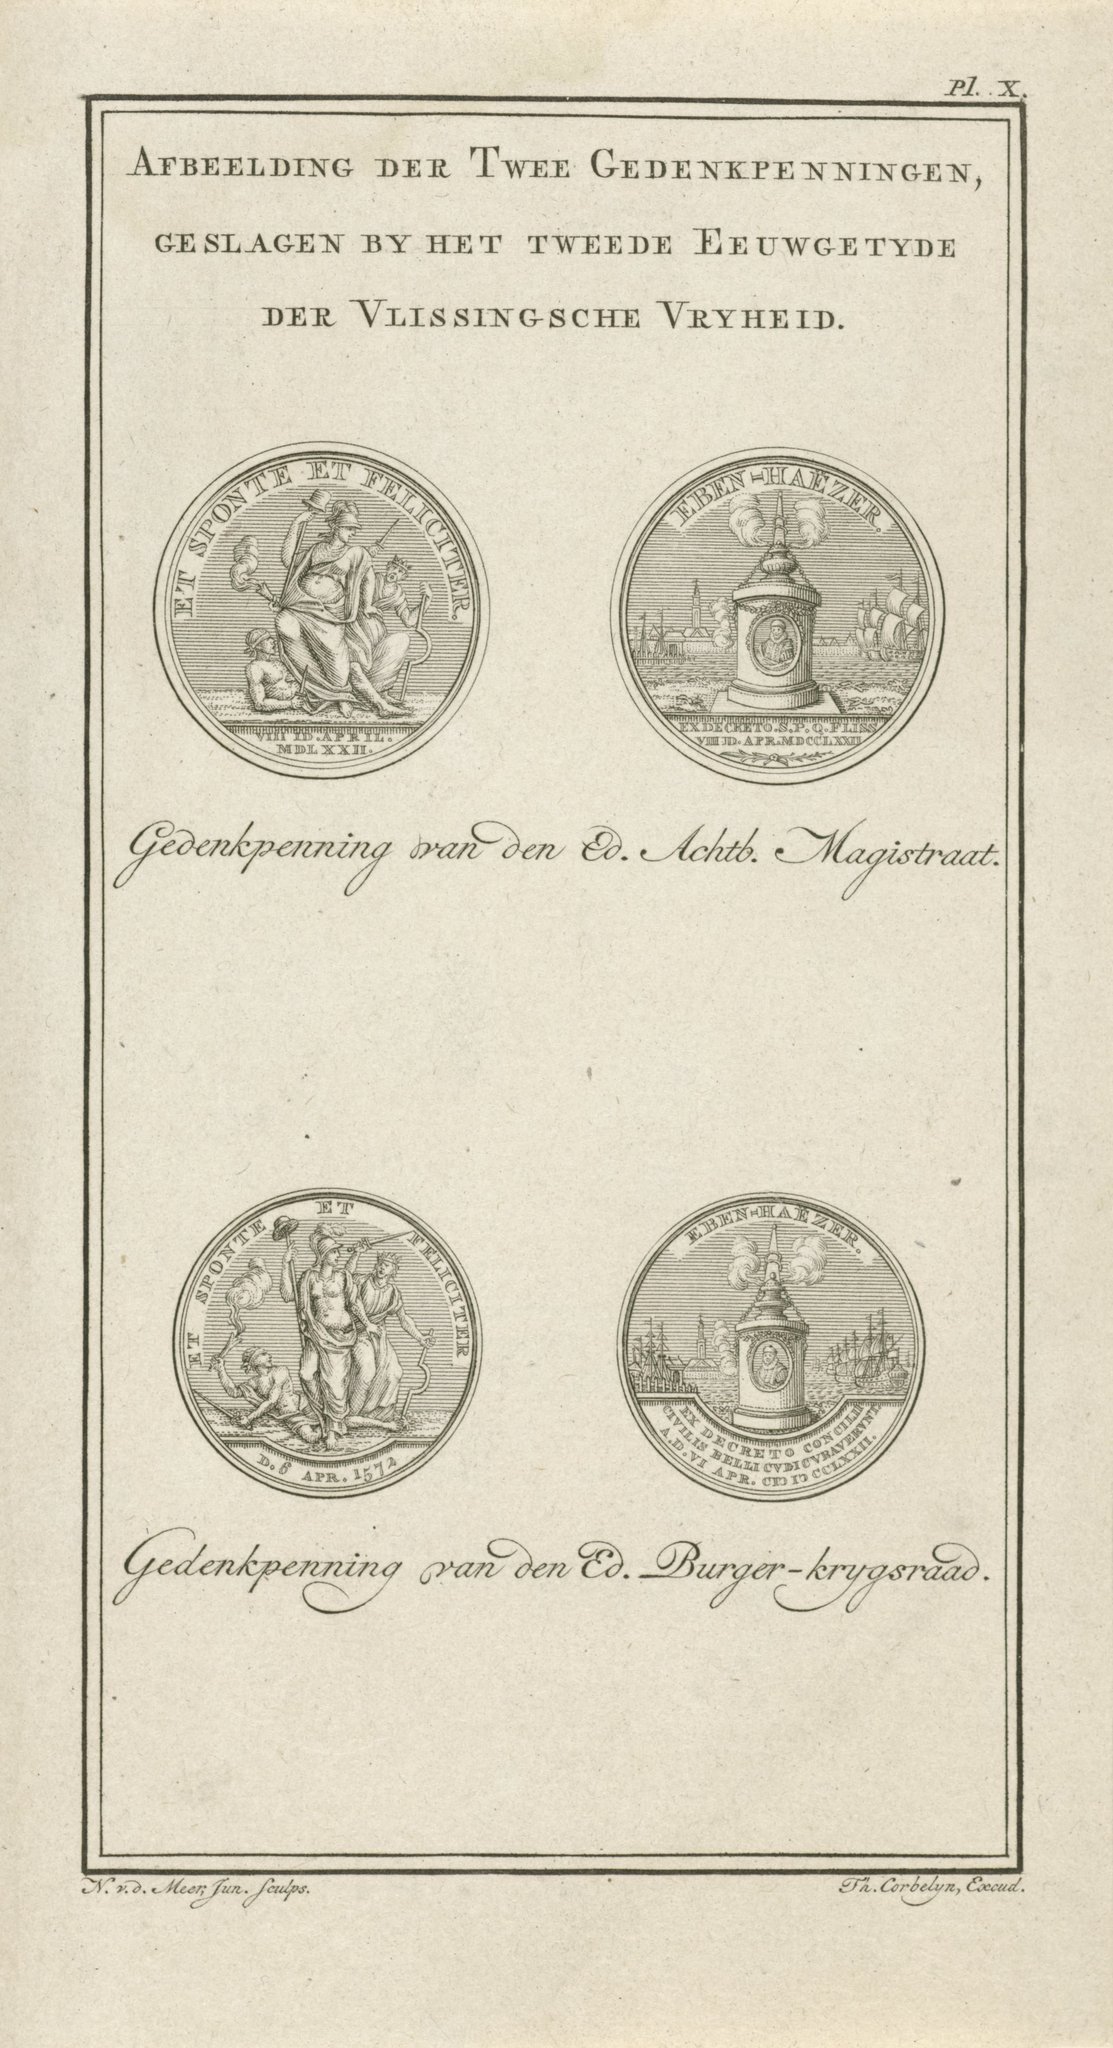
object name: print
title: Afbeelding der Twee Gedenkpenningen, geslagen by het tweede Eeuwgetyde der Vlissingsche Vryheid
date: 1772-1773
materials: paper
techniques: engraving, etching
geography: flushing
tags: medal (considered as a piece of sculpture, regardless of its specific function), flushing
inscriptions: collector's mark: Lugt 2228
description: Twee penningen geslagen bij de viering van 200 jaar vrijheid in Vlissingen, 6 april 1772. De bovenste penning in opdracht van de magistraat van Vlissingen, de onderste door de Burgerkrijgsraad. Genummerd rechtsboven: Pl. X. Onderdeel van een groep van negen platen genummerd I-X van de decoraties bij dit feest.